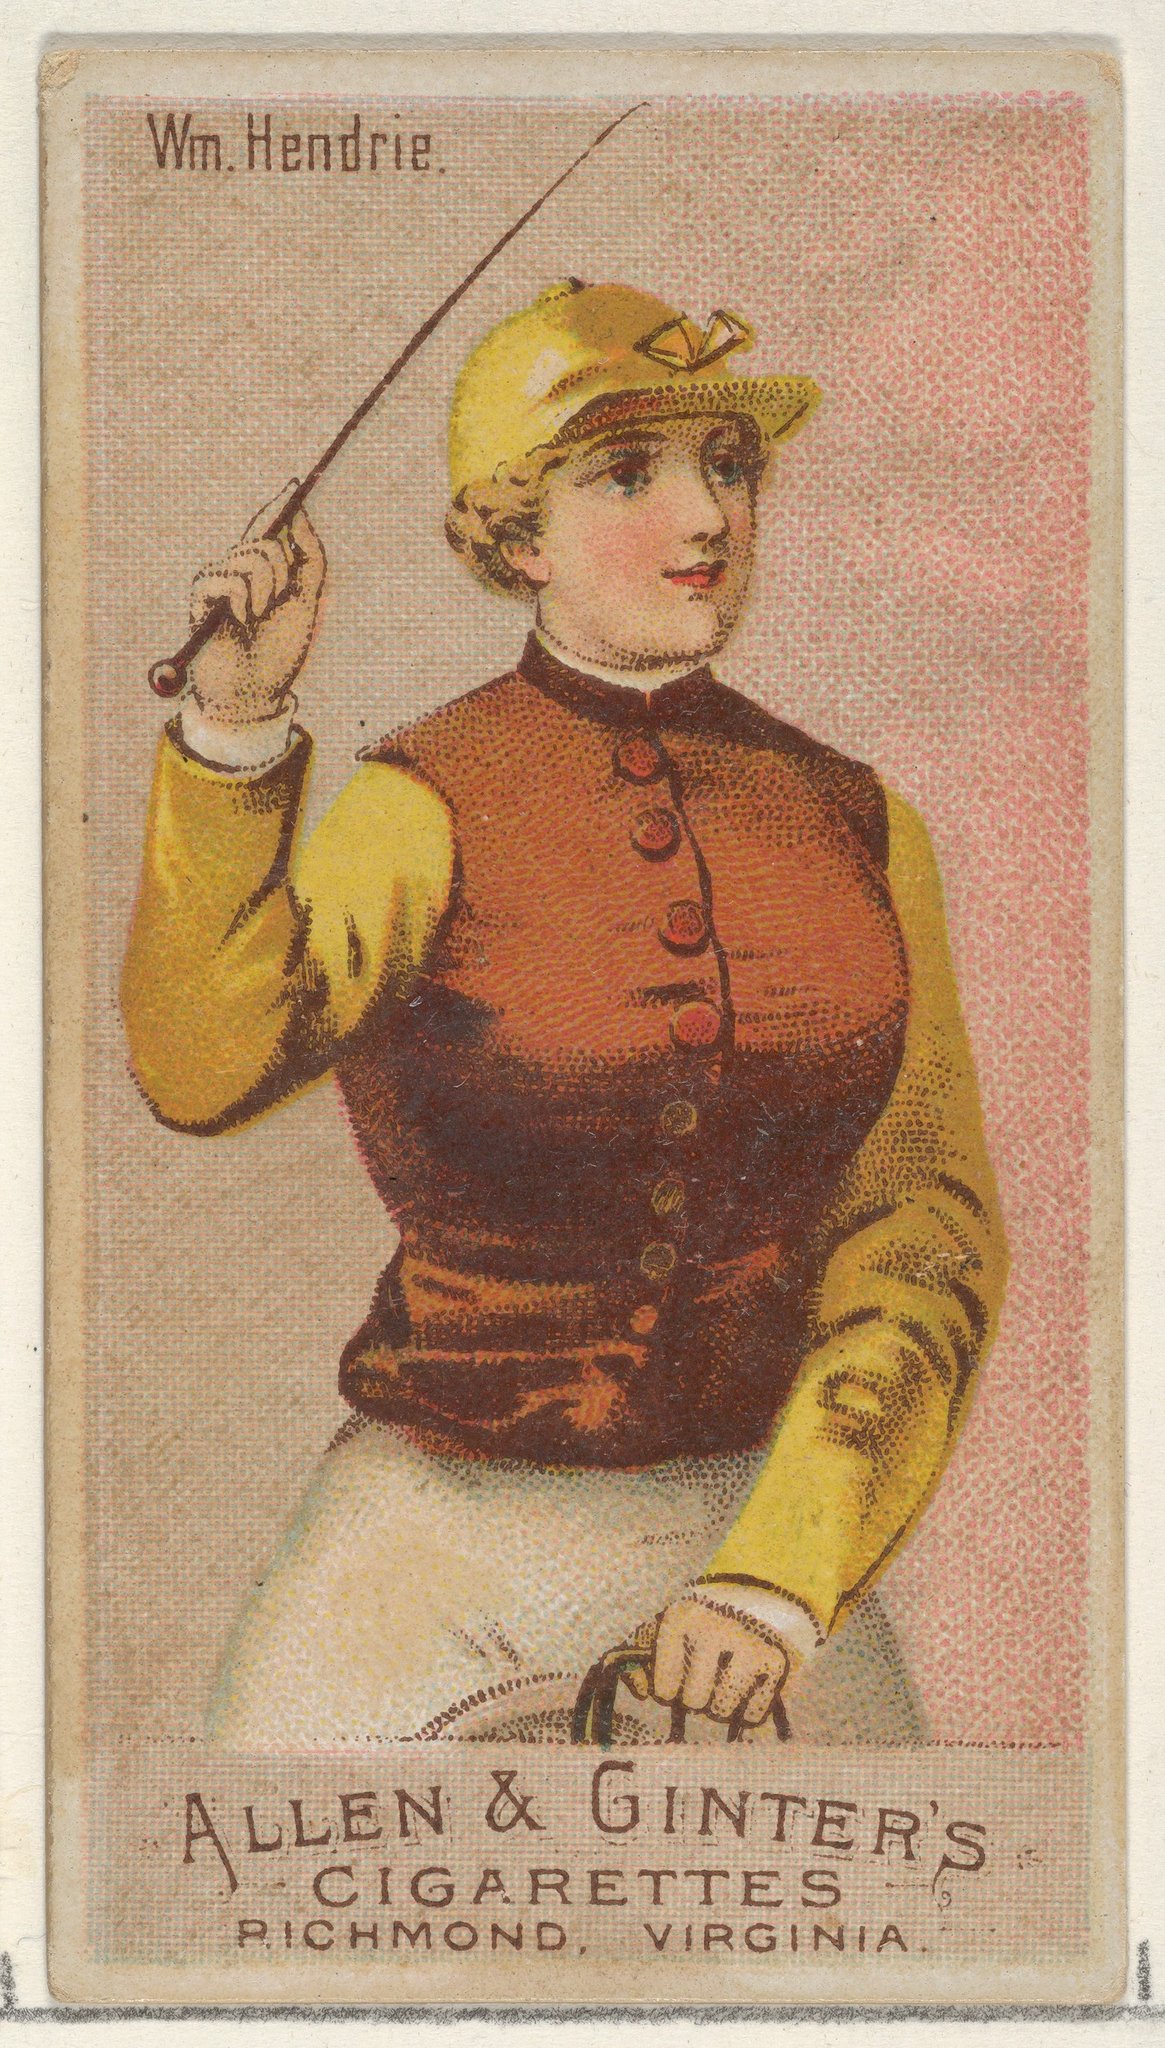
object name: print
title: William Hendrie, from the Racing Colors of the World series (N22a) for Allen & Ginter Cigarettes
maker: allen & ginter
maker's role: publisher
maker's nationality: american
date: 1888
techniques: color lithograph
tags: women,jockeys